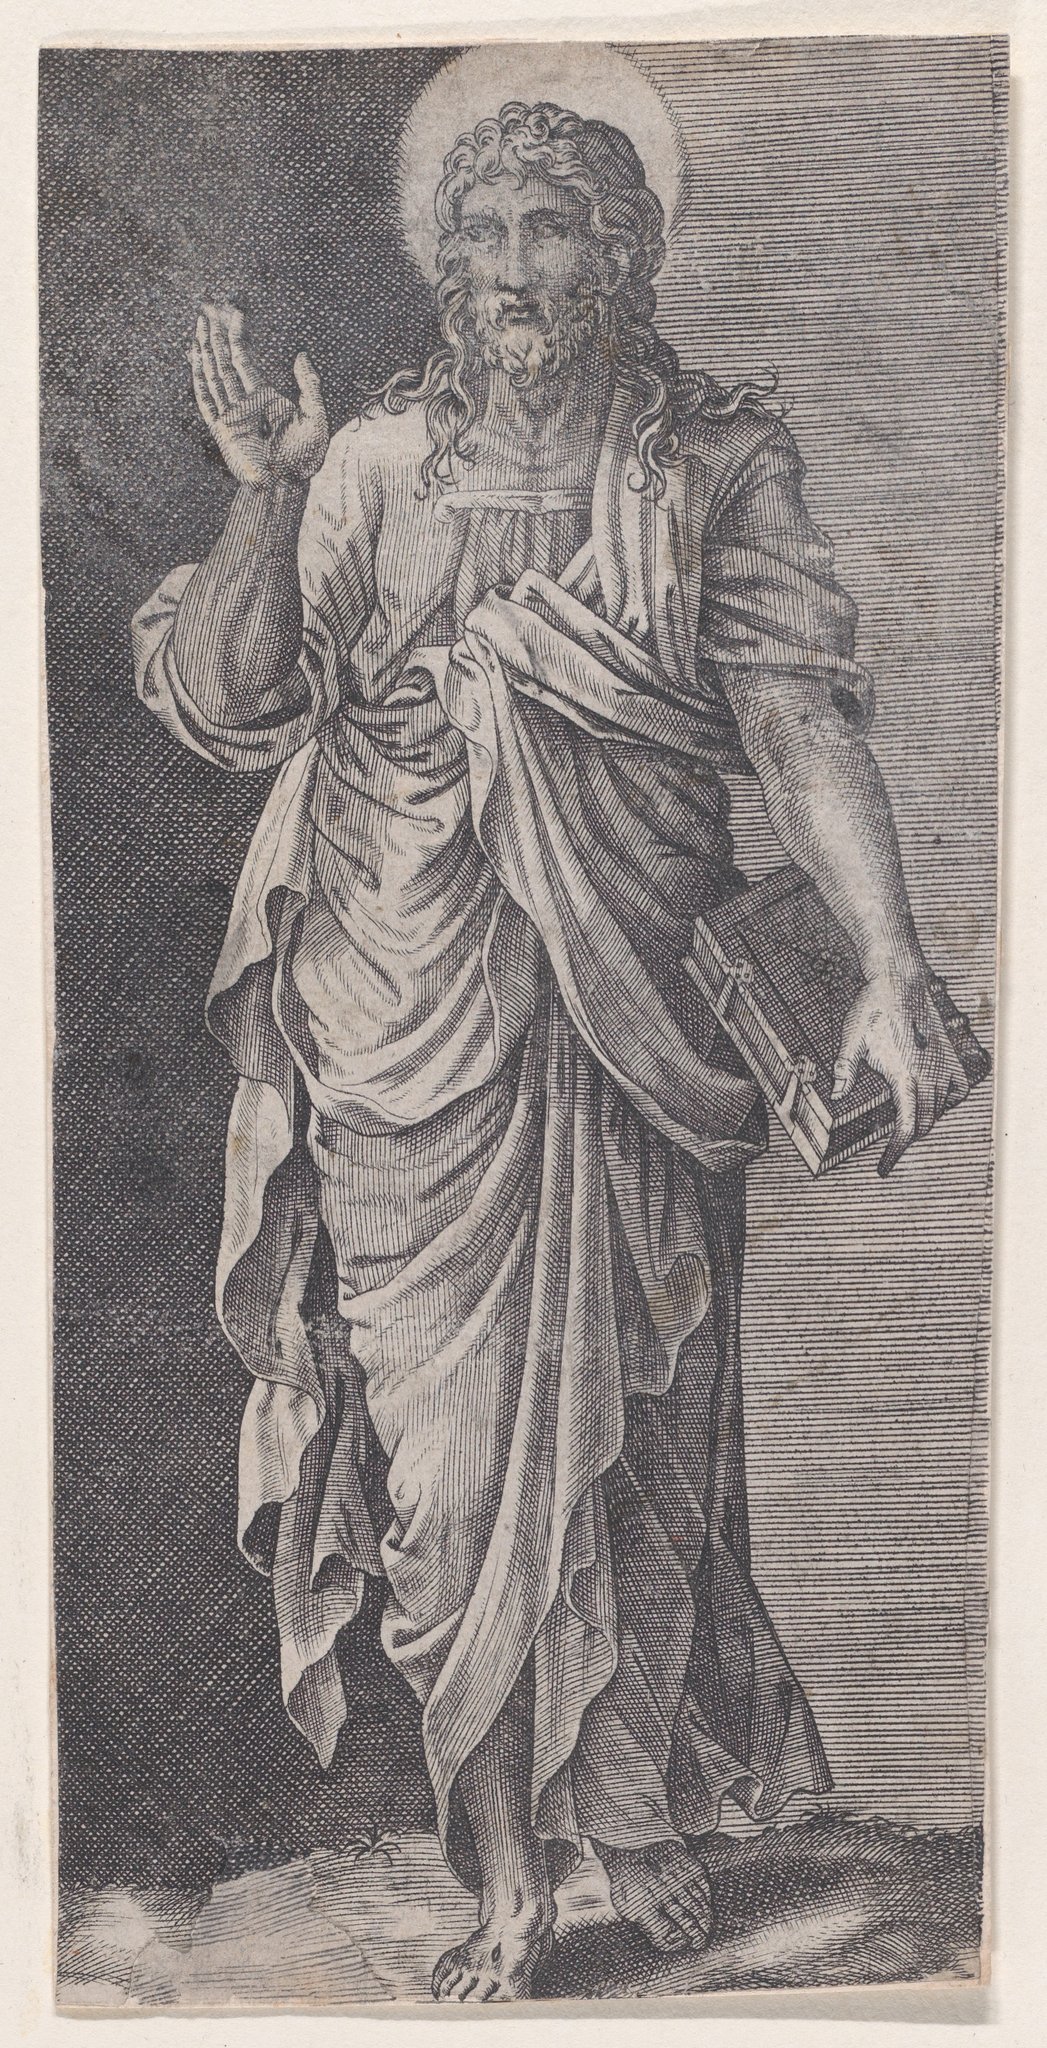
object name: print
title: Christ, from "Christ and the Apostles"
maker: lambert suavius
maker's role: artist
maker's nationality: netherlandish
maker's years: 1510-1576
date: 1530-1576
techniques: backing, engraving